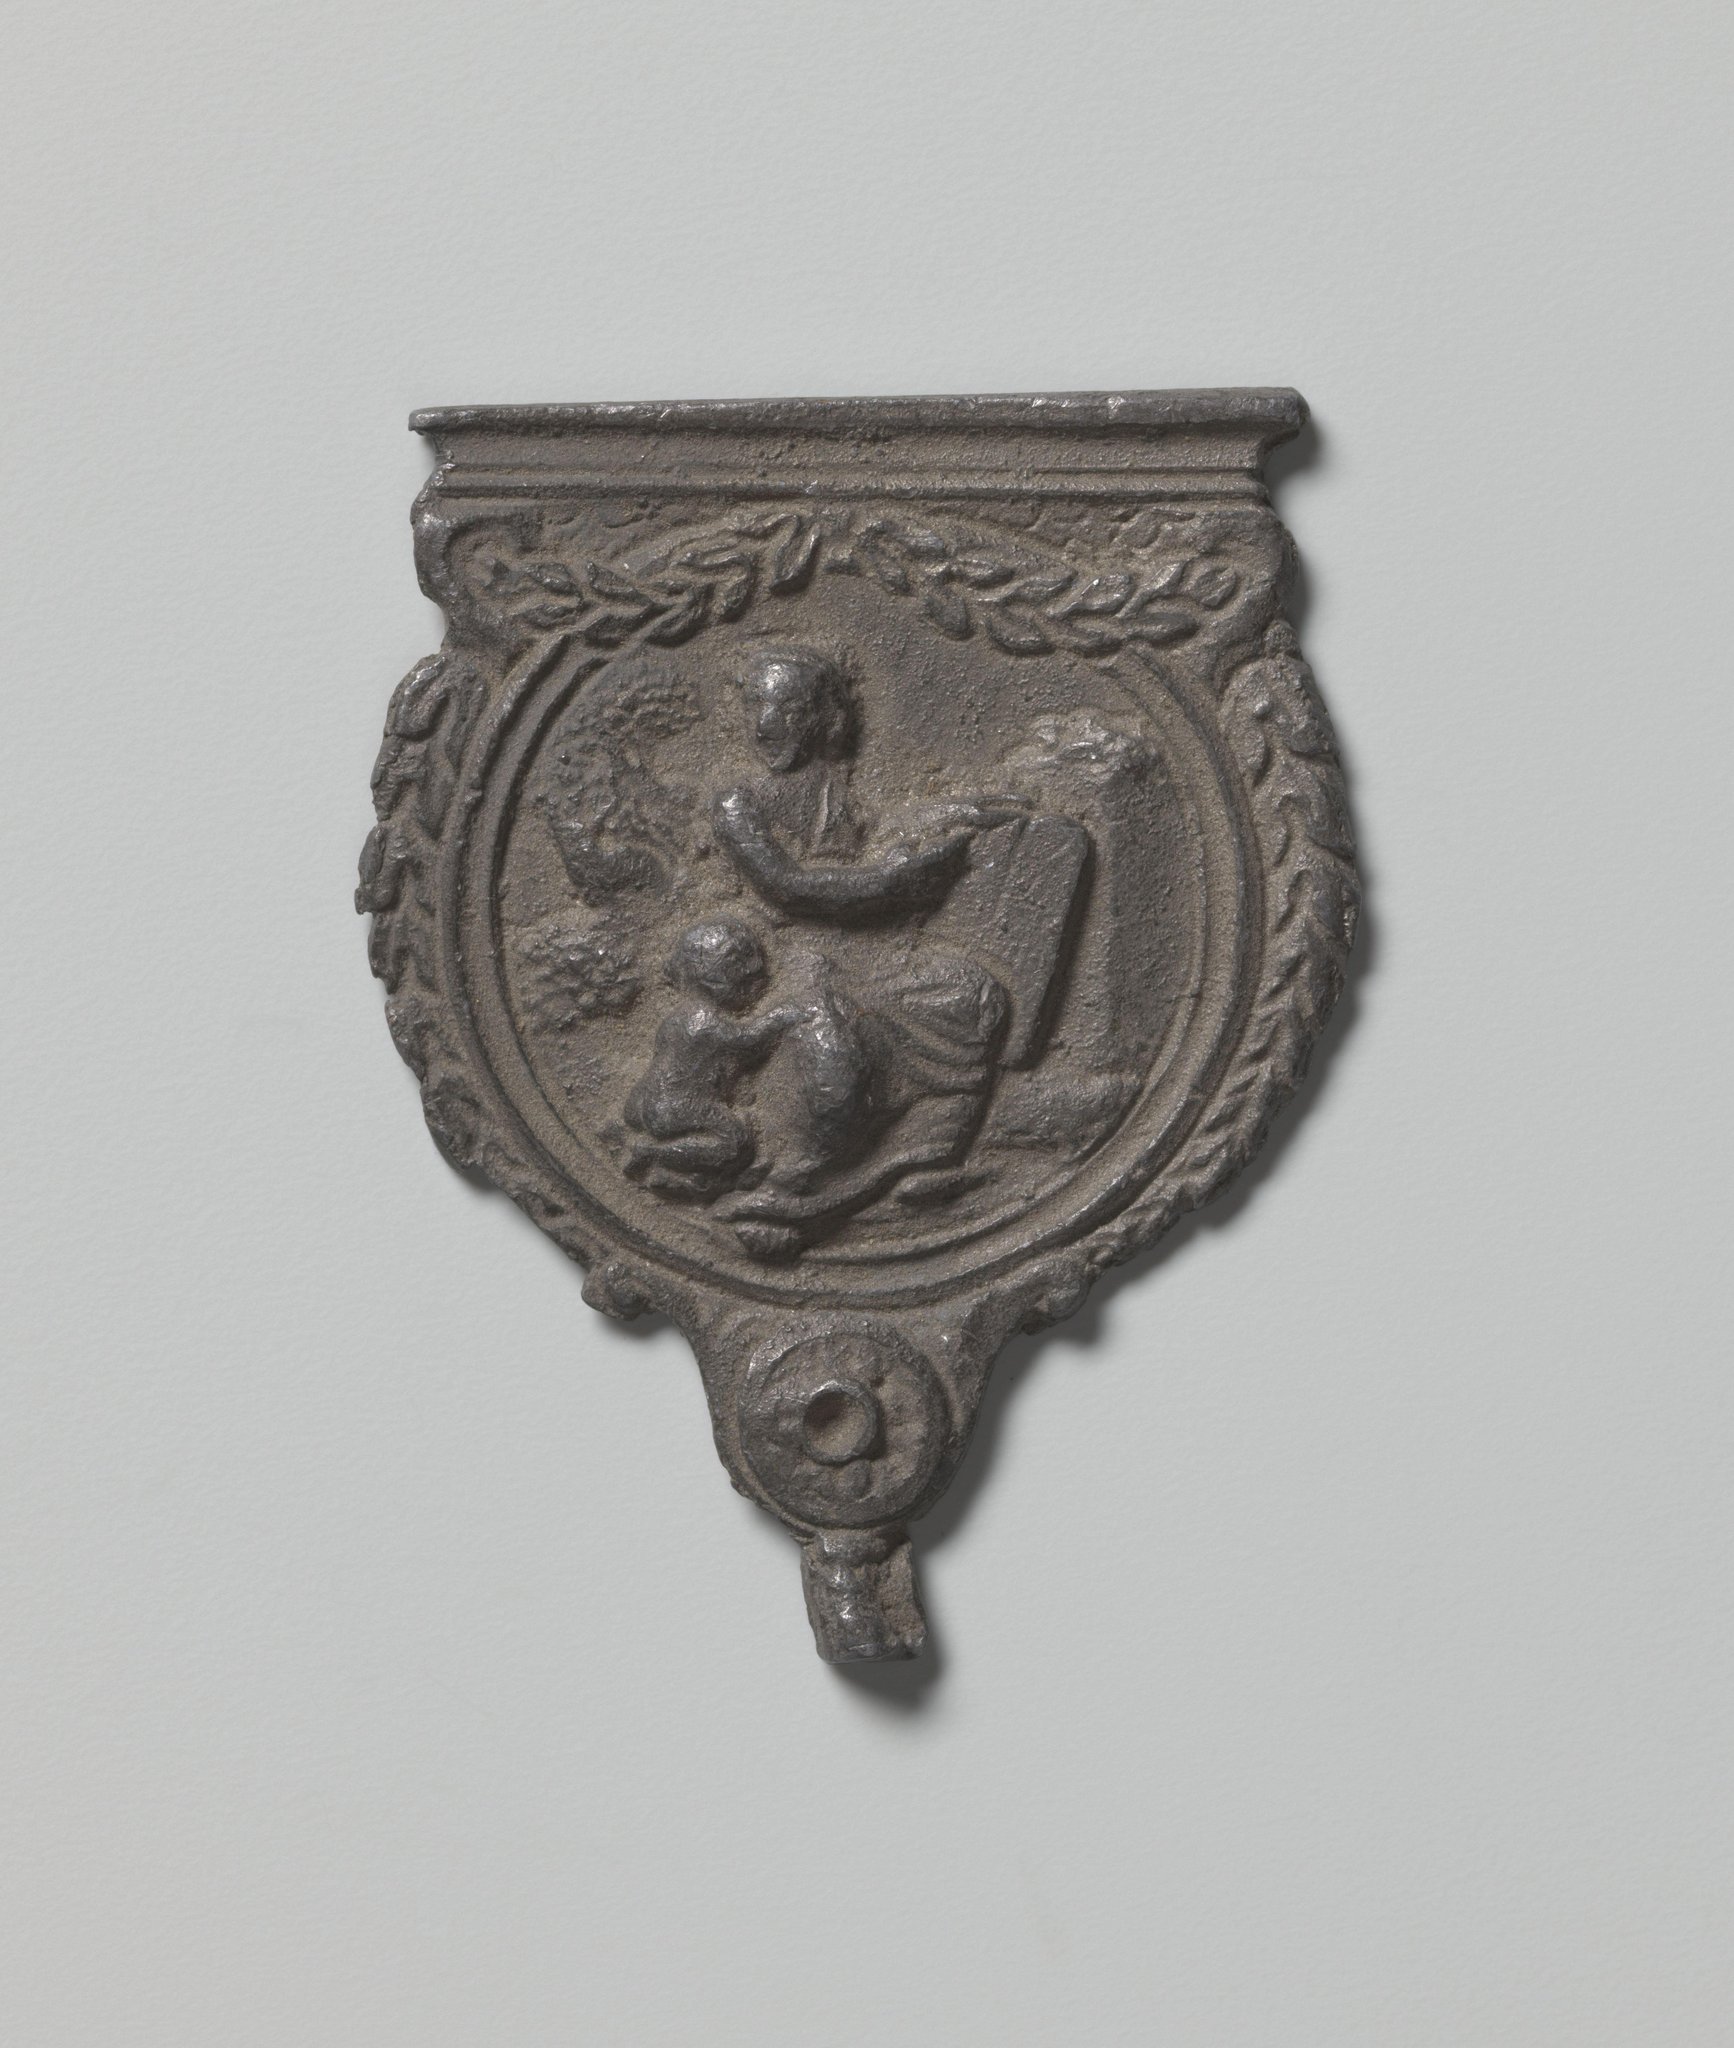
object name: boekslot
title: Model voor een klamp van een boekslot met een zittend figuur met wetstafel en kind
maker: Anonymous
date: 1750-1775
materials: tin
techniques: metalworking, cutting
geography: amsterdam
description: Model van tin voor een gietvorm van een klamp van een boekslot. De voorstelling toont een zittend figuur die een wetstafel toont aan een kind. Het geheel is gevat in een medaillon omringd met guirlandes en onderaan een cirkelvormige uitstulping. De bovenzijde is recht.